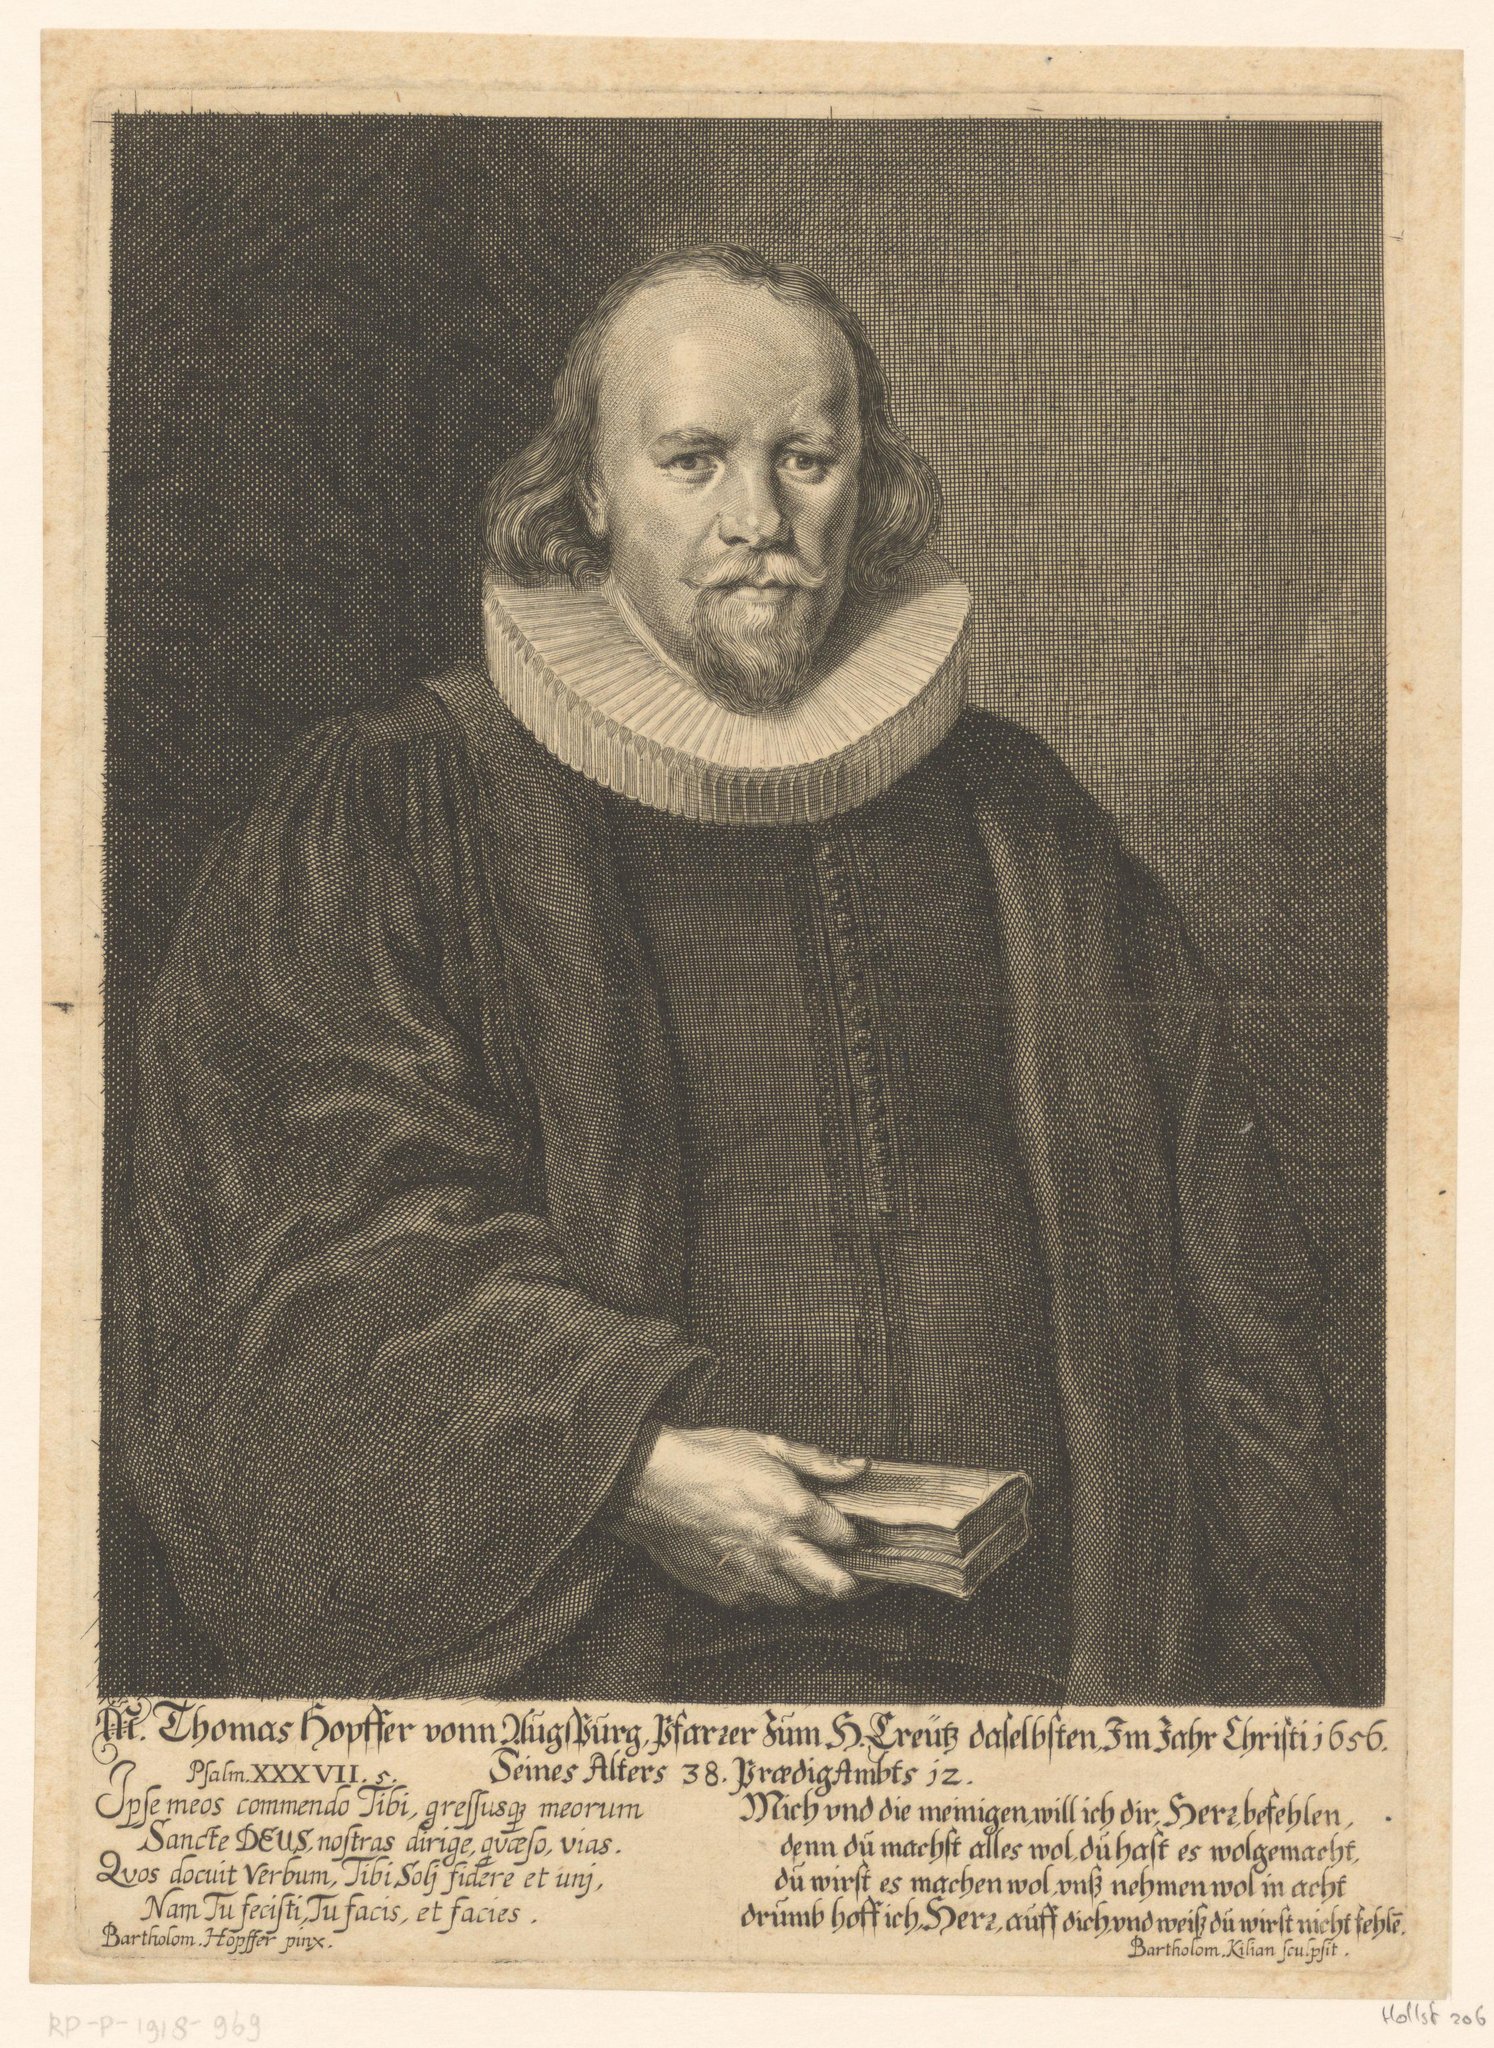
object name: print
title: Portret van Thomas Hopffer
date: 1656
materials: paper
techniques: engraving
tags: augsburg, theologian, historical persons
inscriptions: collector's mark: Lugt 2233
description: In de marge onderaan tekst uit Psalm 37:5 in het Latijn en Duits.